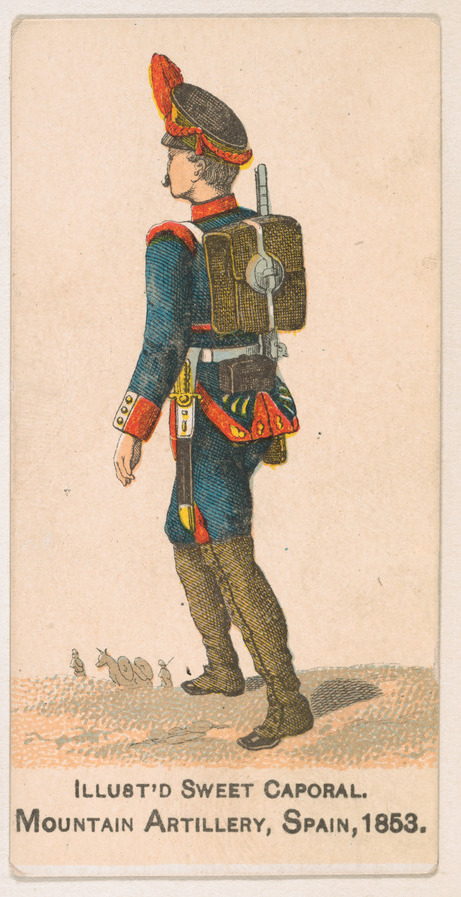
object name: print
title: Mountain Artillery, Spain, 1853, from the Military Series (N224) issued by Kinney Tobacco Company to promote Sweet Caporal Cigarettes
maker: kinney brothers tobacco company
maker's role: publisher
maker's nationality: american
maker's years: 1869-2011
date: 1888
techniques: color lithograph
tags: military,weapons,men,profiles